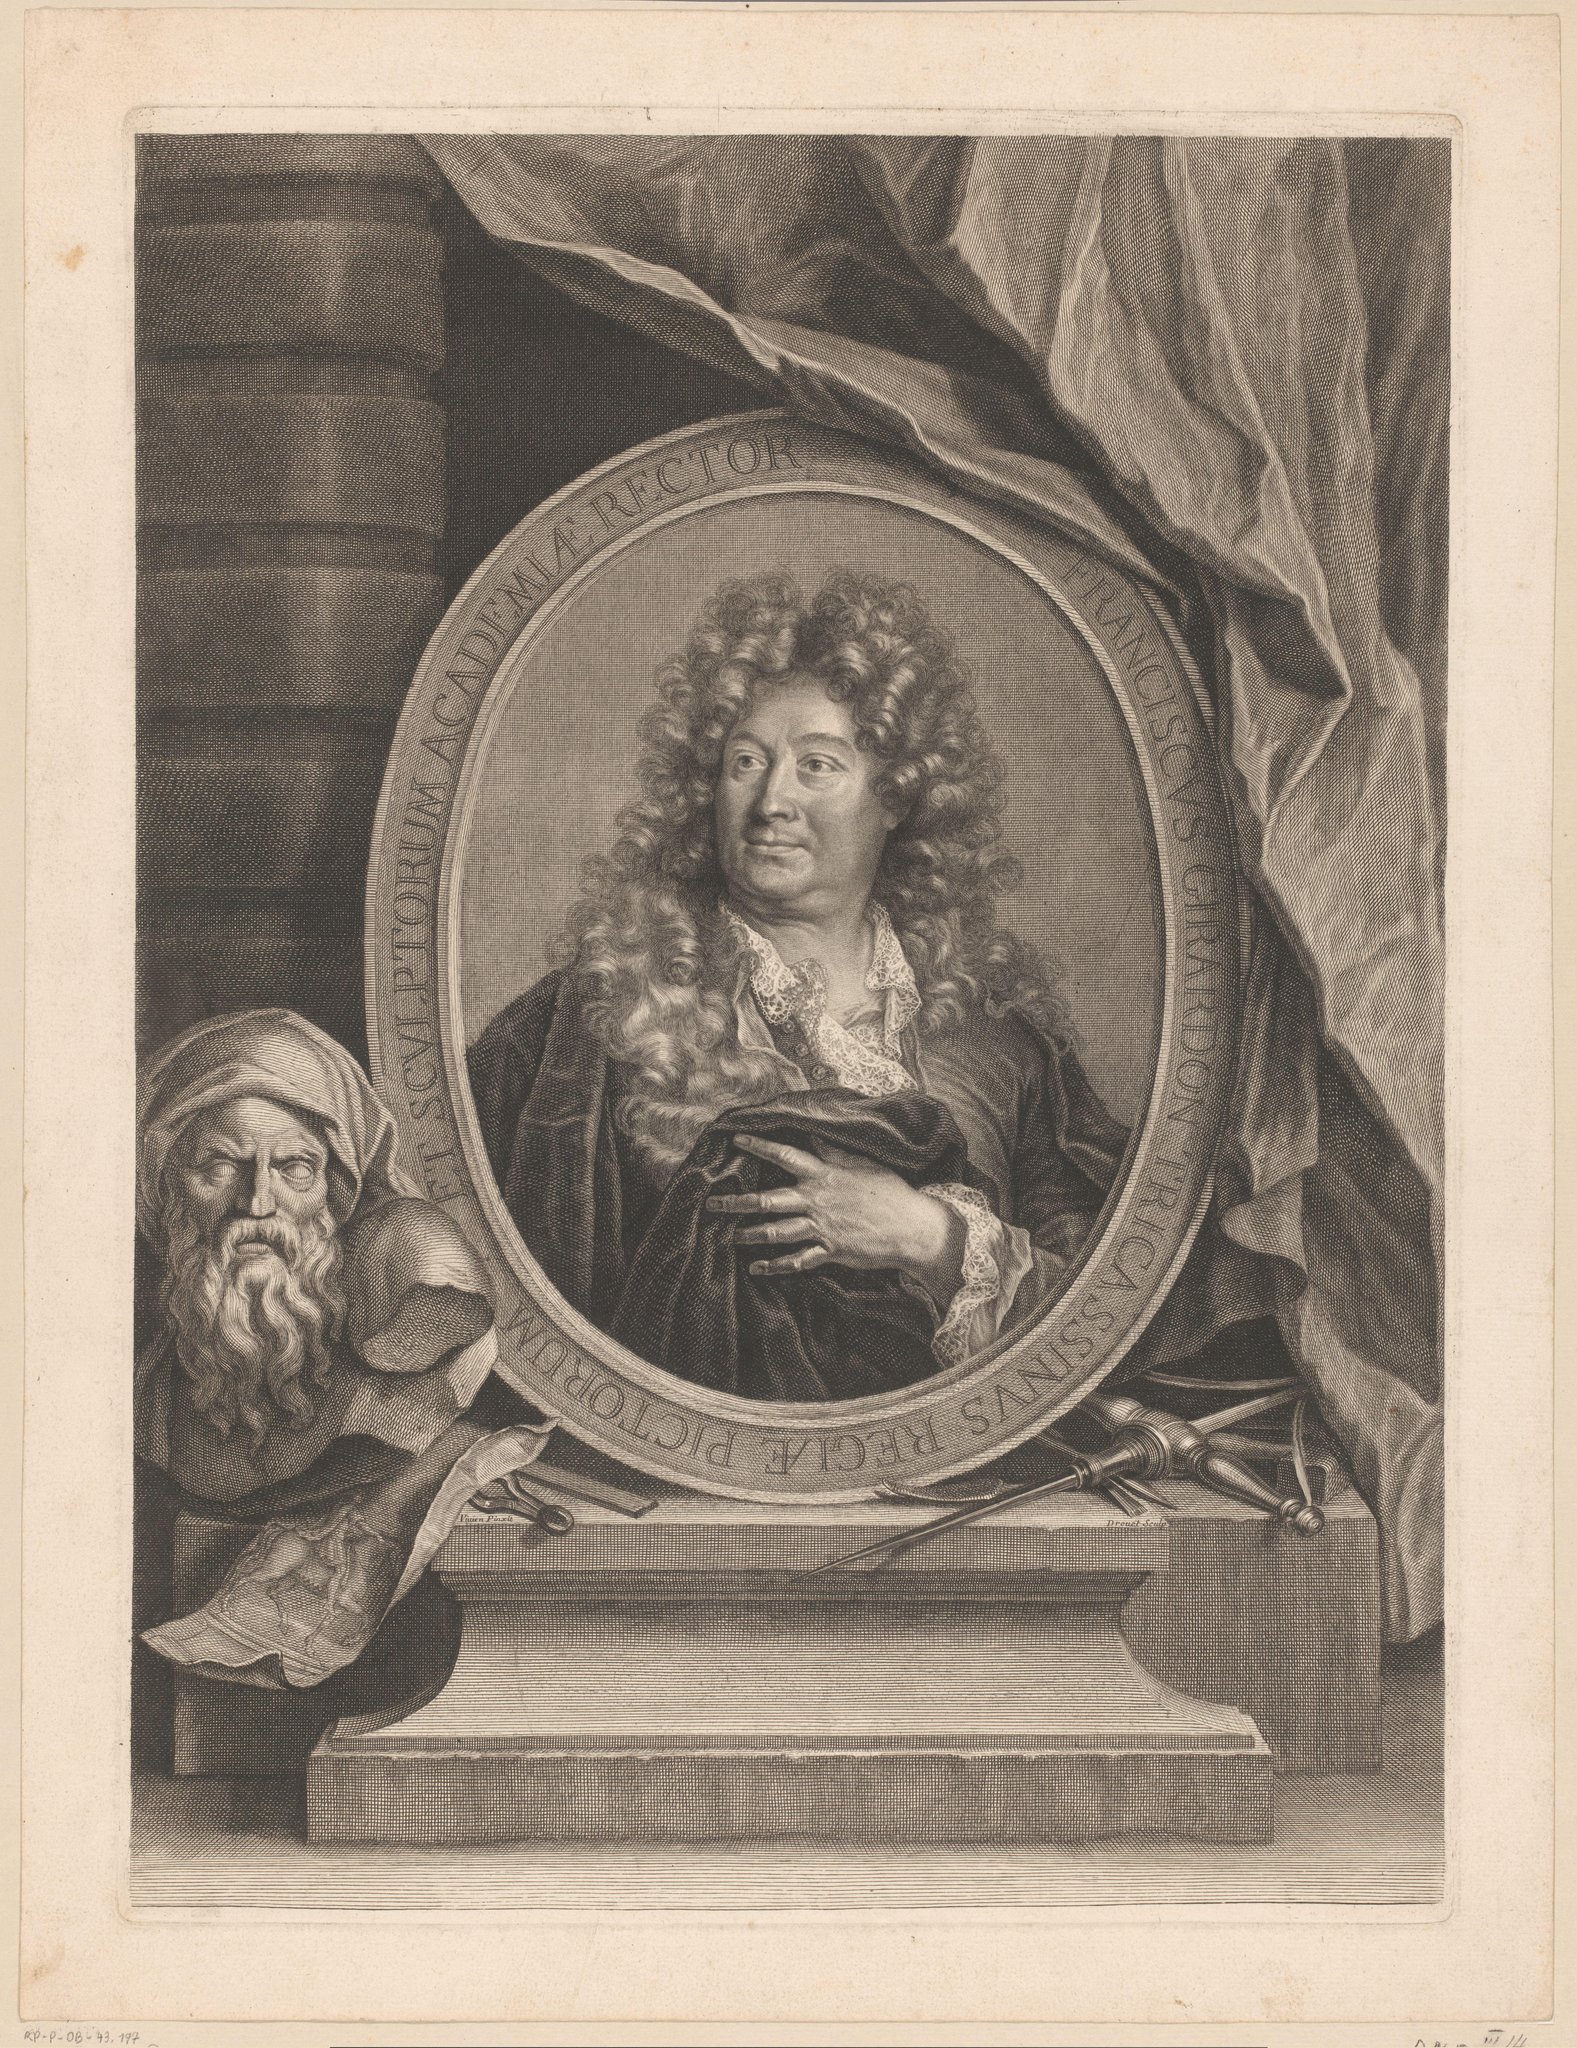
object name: print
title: Franciscus Girardon tricassinus regiae pictorum et sculptorum academiae rector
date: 1673-1738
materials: paper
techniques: engraving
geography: france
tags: françois girardon, portrait, self-portrait of sculptor, ornament ~ medallion, portrait, self-portrait of painter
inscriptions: collector's mark: Lugt 240